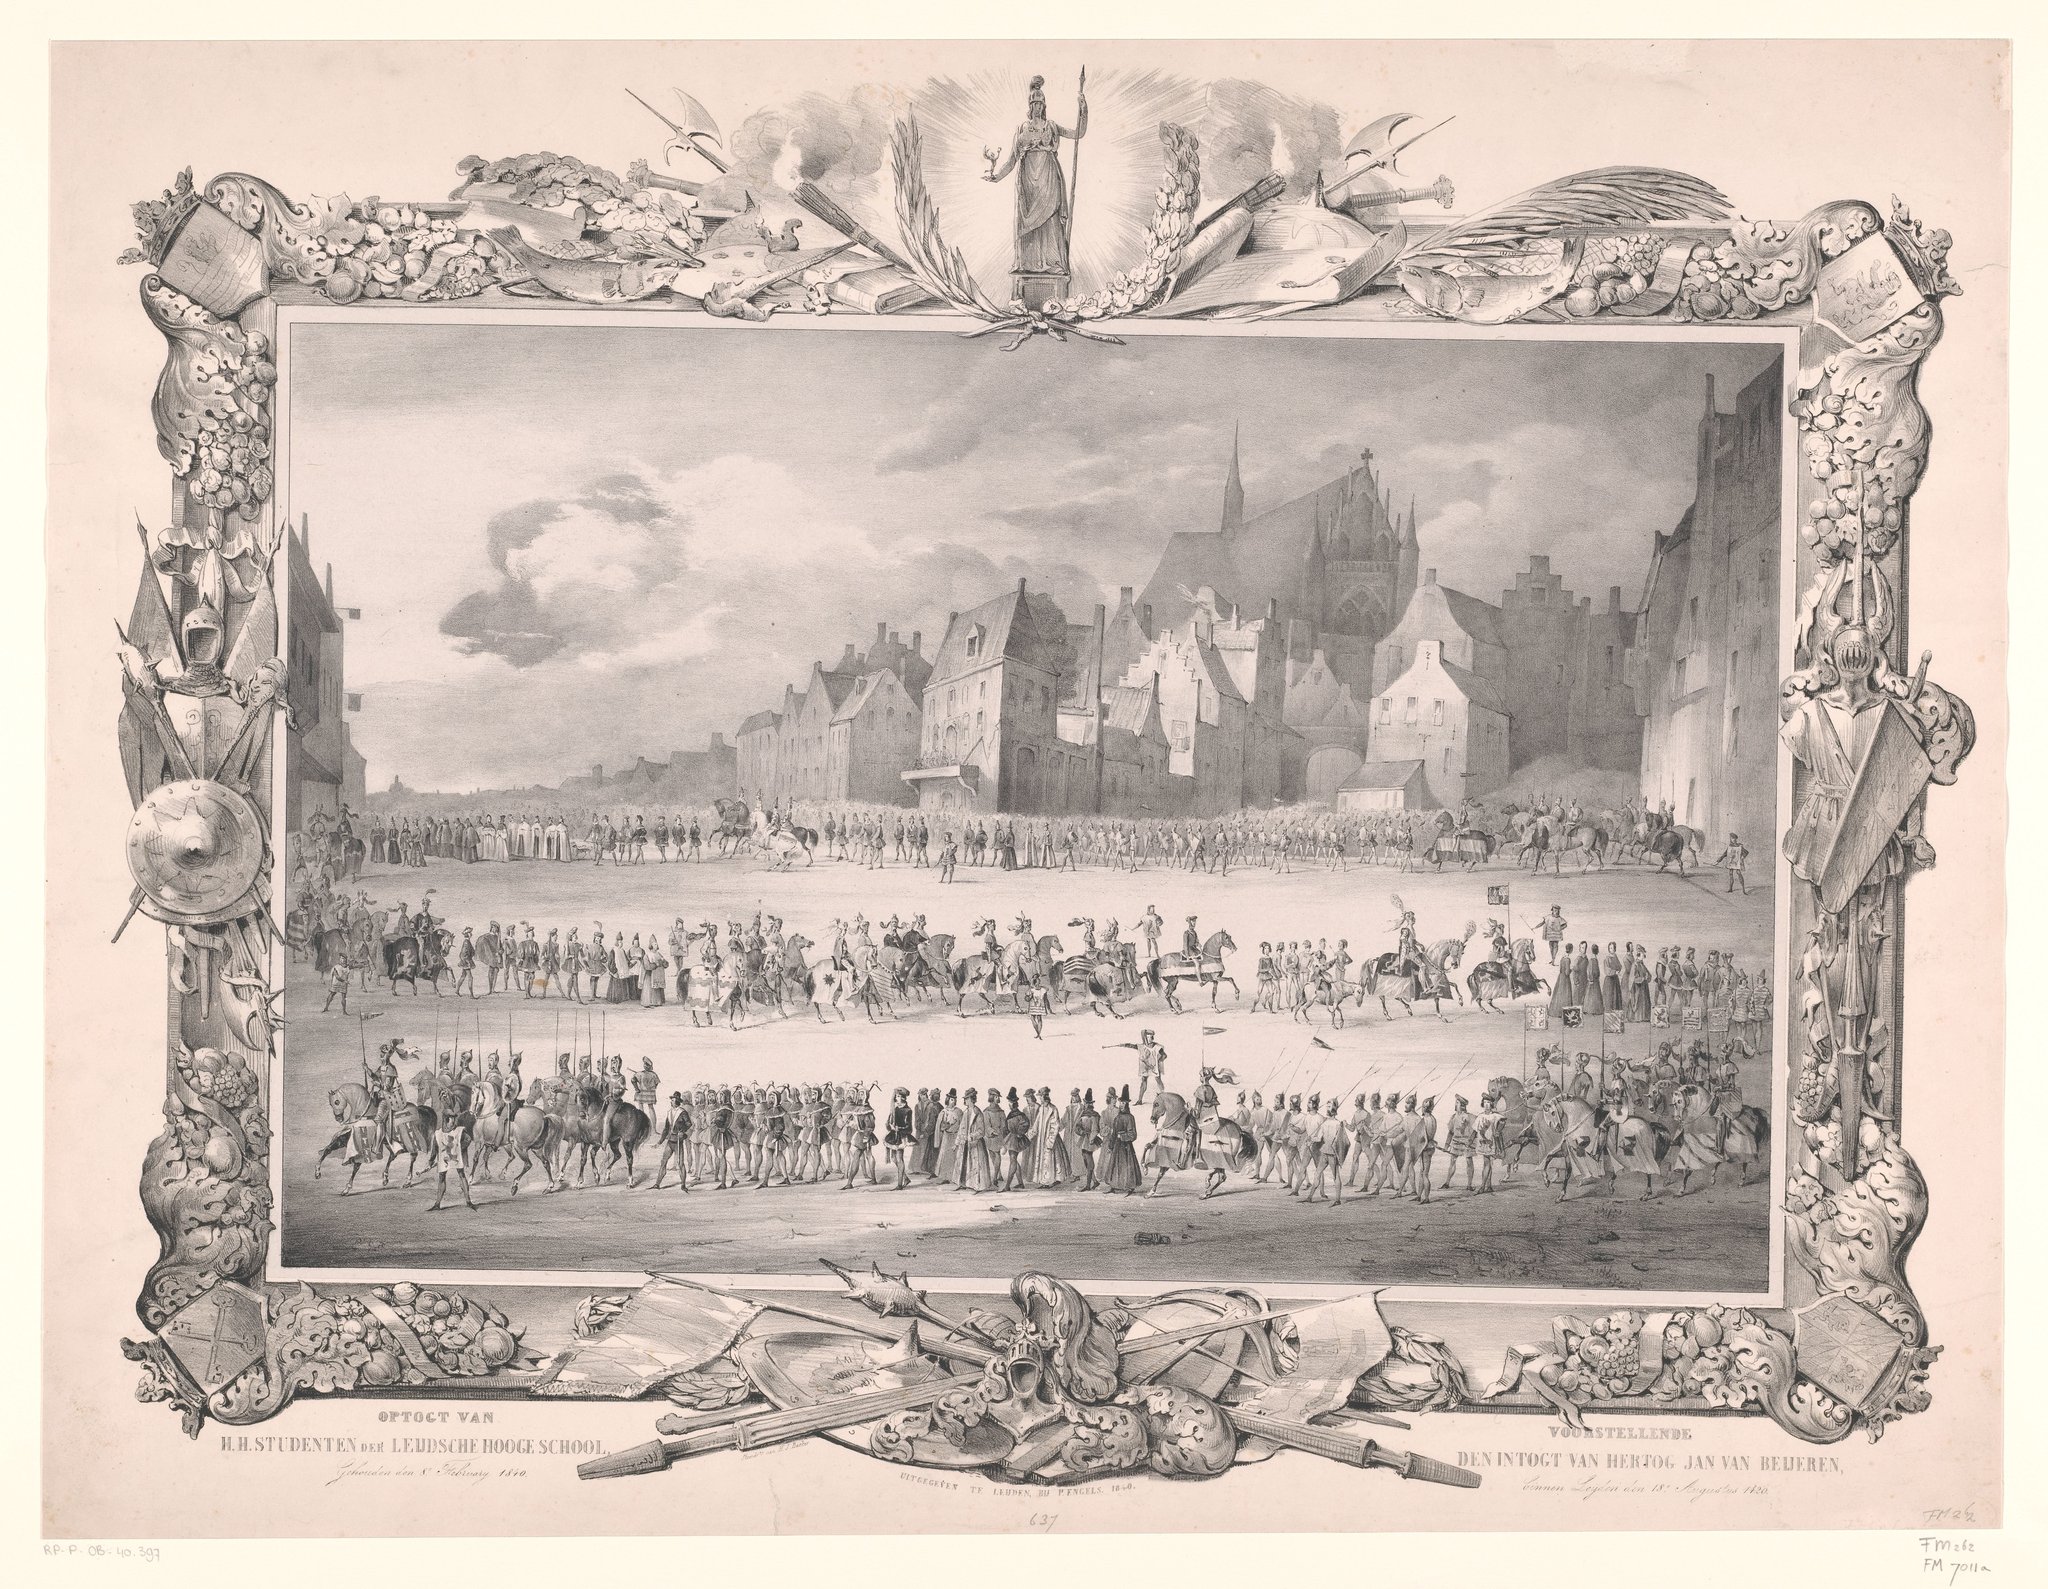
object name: print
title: Optogt van H.H. studenten der Leijdsche Hooge School, Gehouden den 8e February 1840 / Voorstellende den intogt van hertog Jan van Beijeren, binnen Leijden den 18e Augustus 1420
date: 1840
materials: paper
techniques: lithograph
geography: dordrecht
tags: jan van beieren, students' pageant, costumes used in pageants, leiden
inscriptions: collector's mark: Lugt 2228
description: Historische gekostumeerde optocht door de studenten van Leidse Hogeschool op 8 februari 1840, ter viering van de 265ste verjaardag van de universiteit. Het onderwerp van de historische optocht en maskerade is de intocht van hertog Jan van Beieren te Leiden op 18 augustus 1420. Denkbeeldige voorstelling van Leiden in 1420 met de stoet slingerende over een stadsplein. Binnen een omlijsting met festoenen, wapens en bovenaan Minerva.